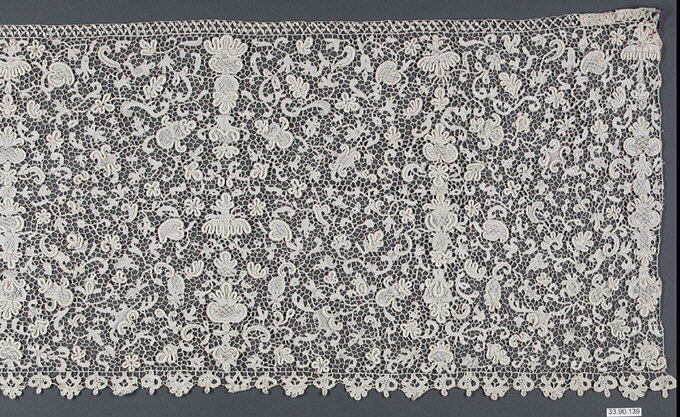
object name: flounce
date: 1701-1733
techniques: lace